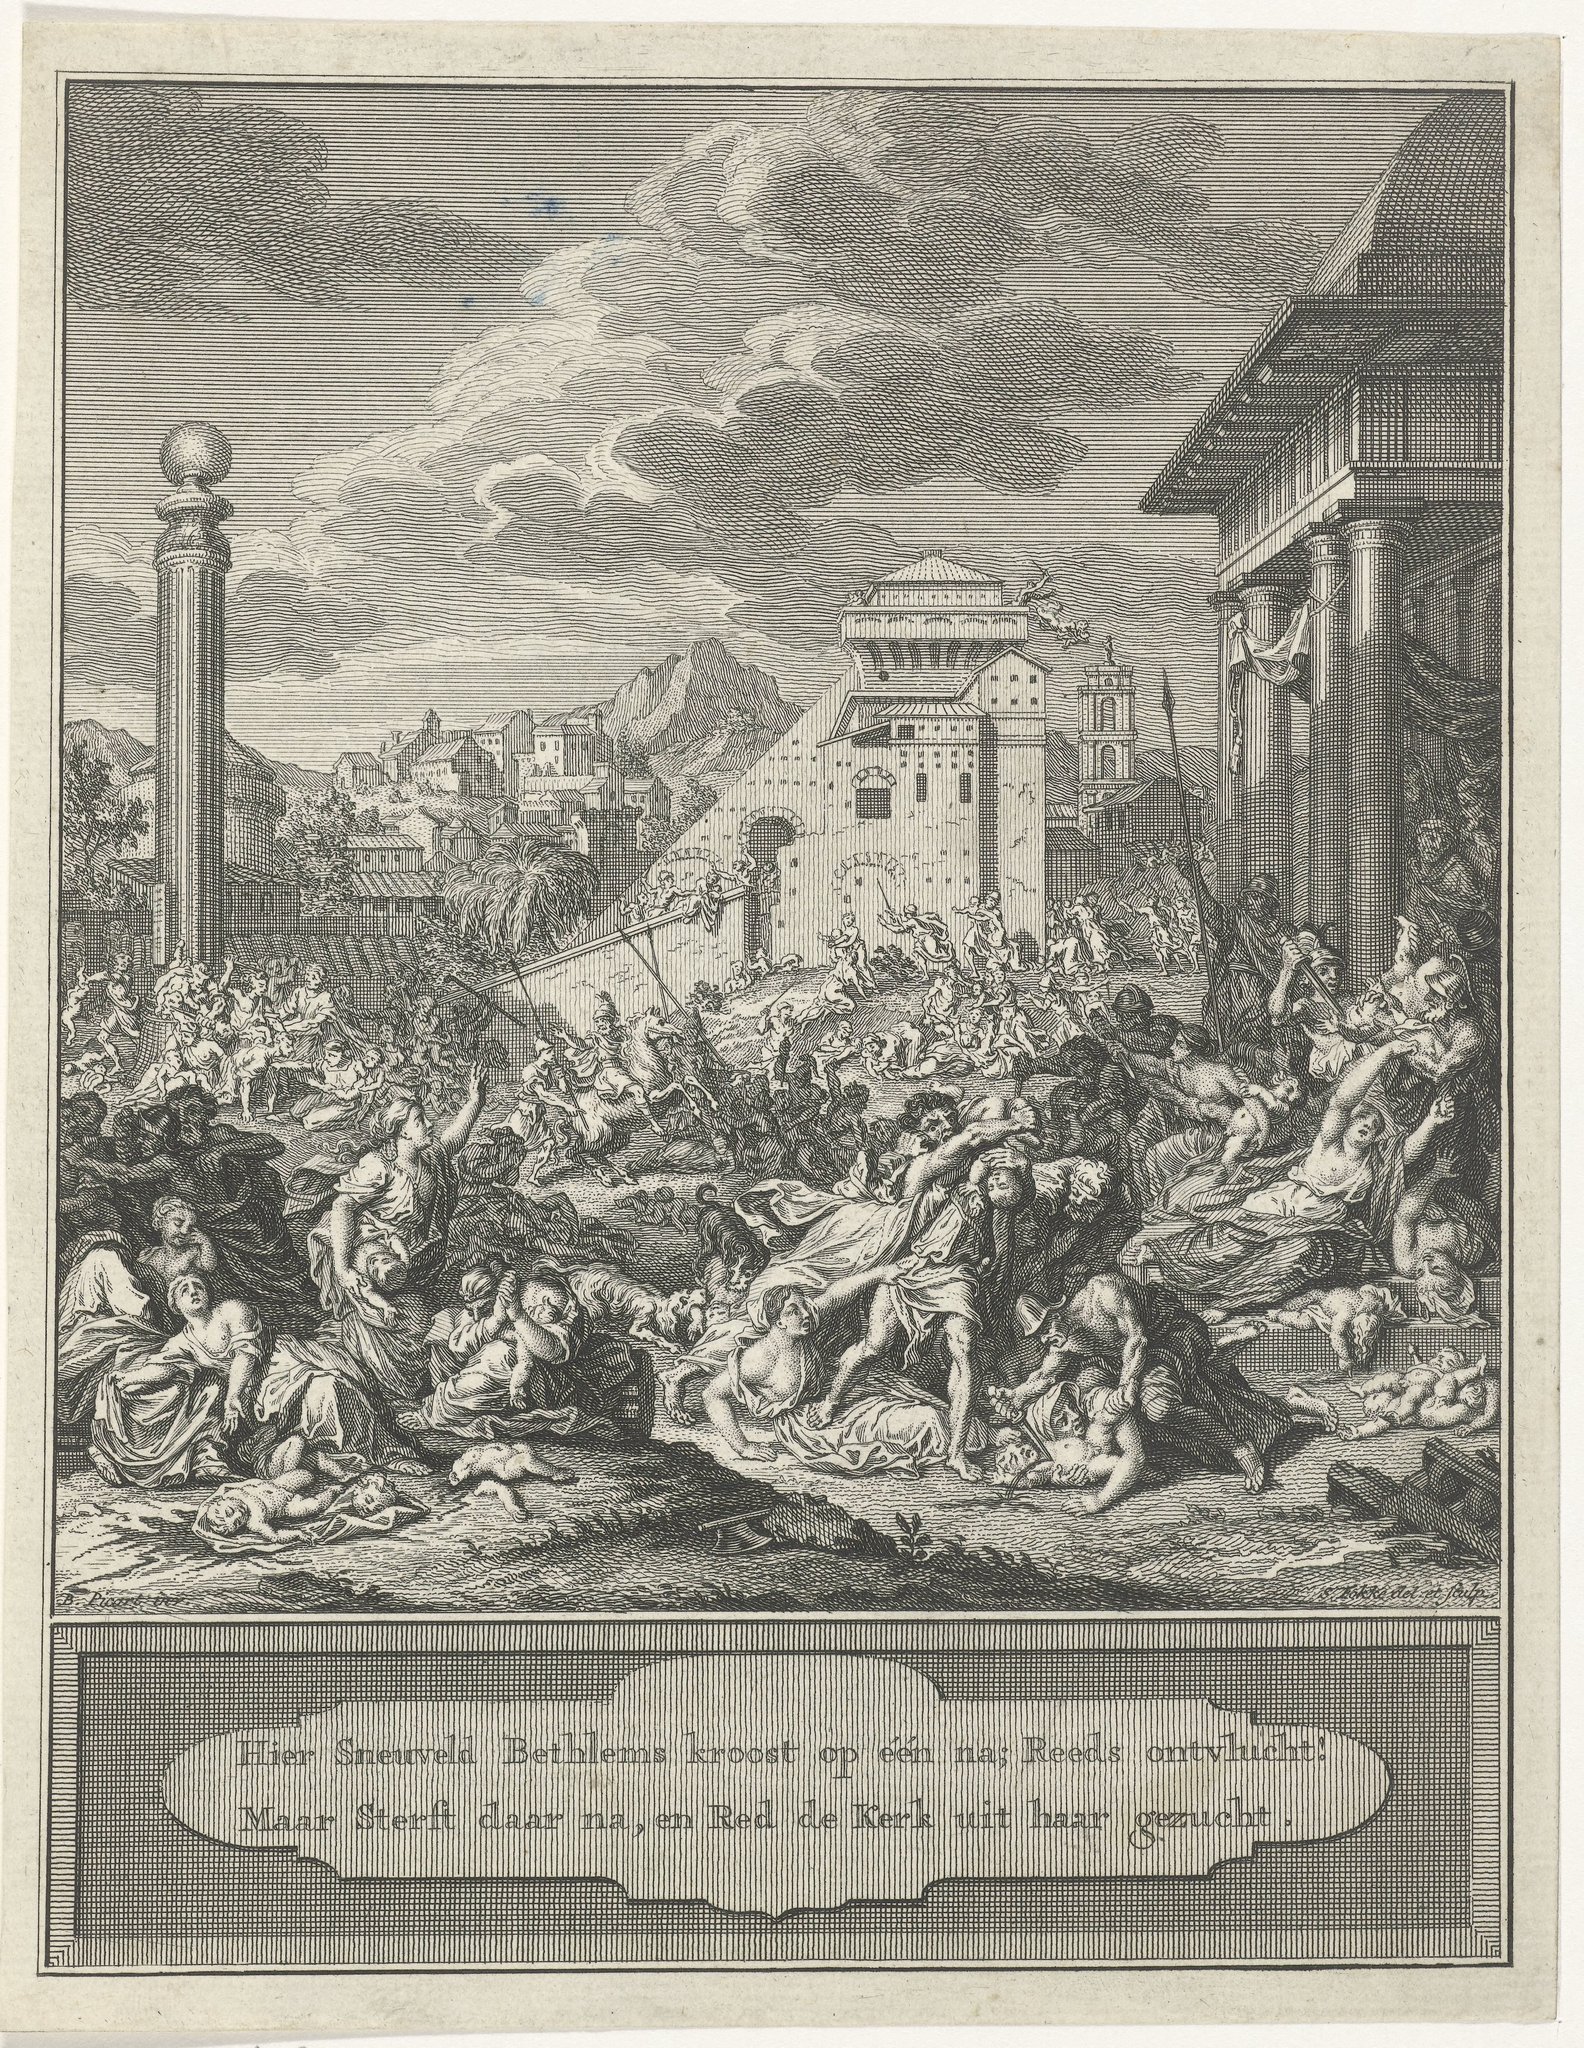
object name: print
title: Kindermoord te Bethlehem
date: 1722-1784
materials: paper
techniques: etching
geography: amsterdam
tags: the massacre of the innocents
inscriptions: collector's mark: Lugt 2228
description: Zicht op de stad Bethlehem waar een grote slachtpartij plaatsvindt. Soldaten rukken kinderen uit de armen van wanhopige moeders om ze met zwaarden te doden. Talloze dode kinderen liggen verspreid over de grond.